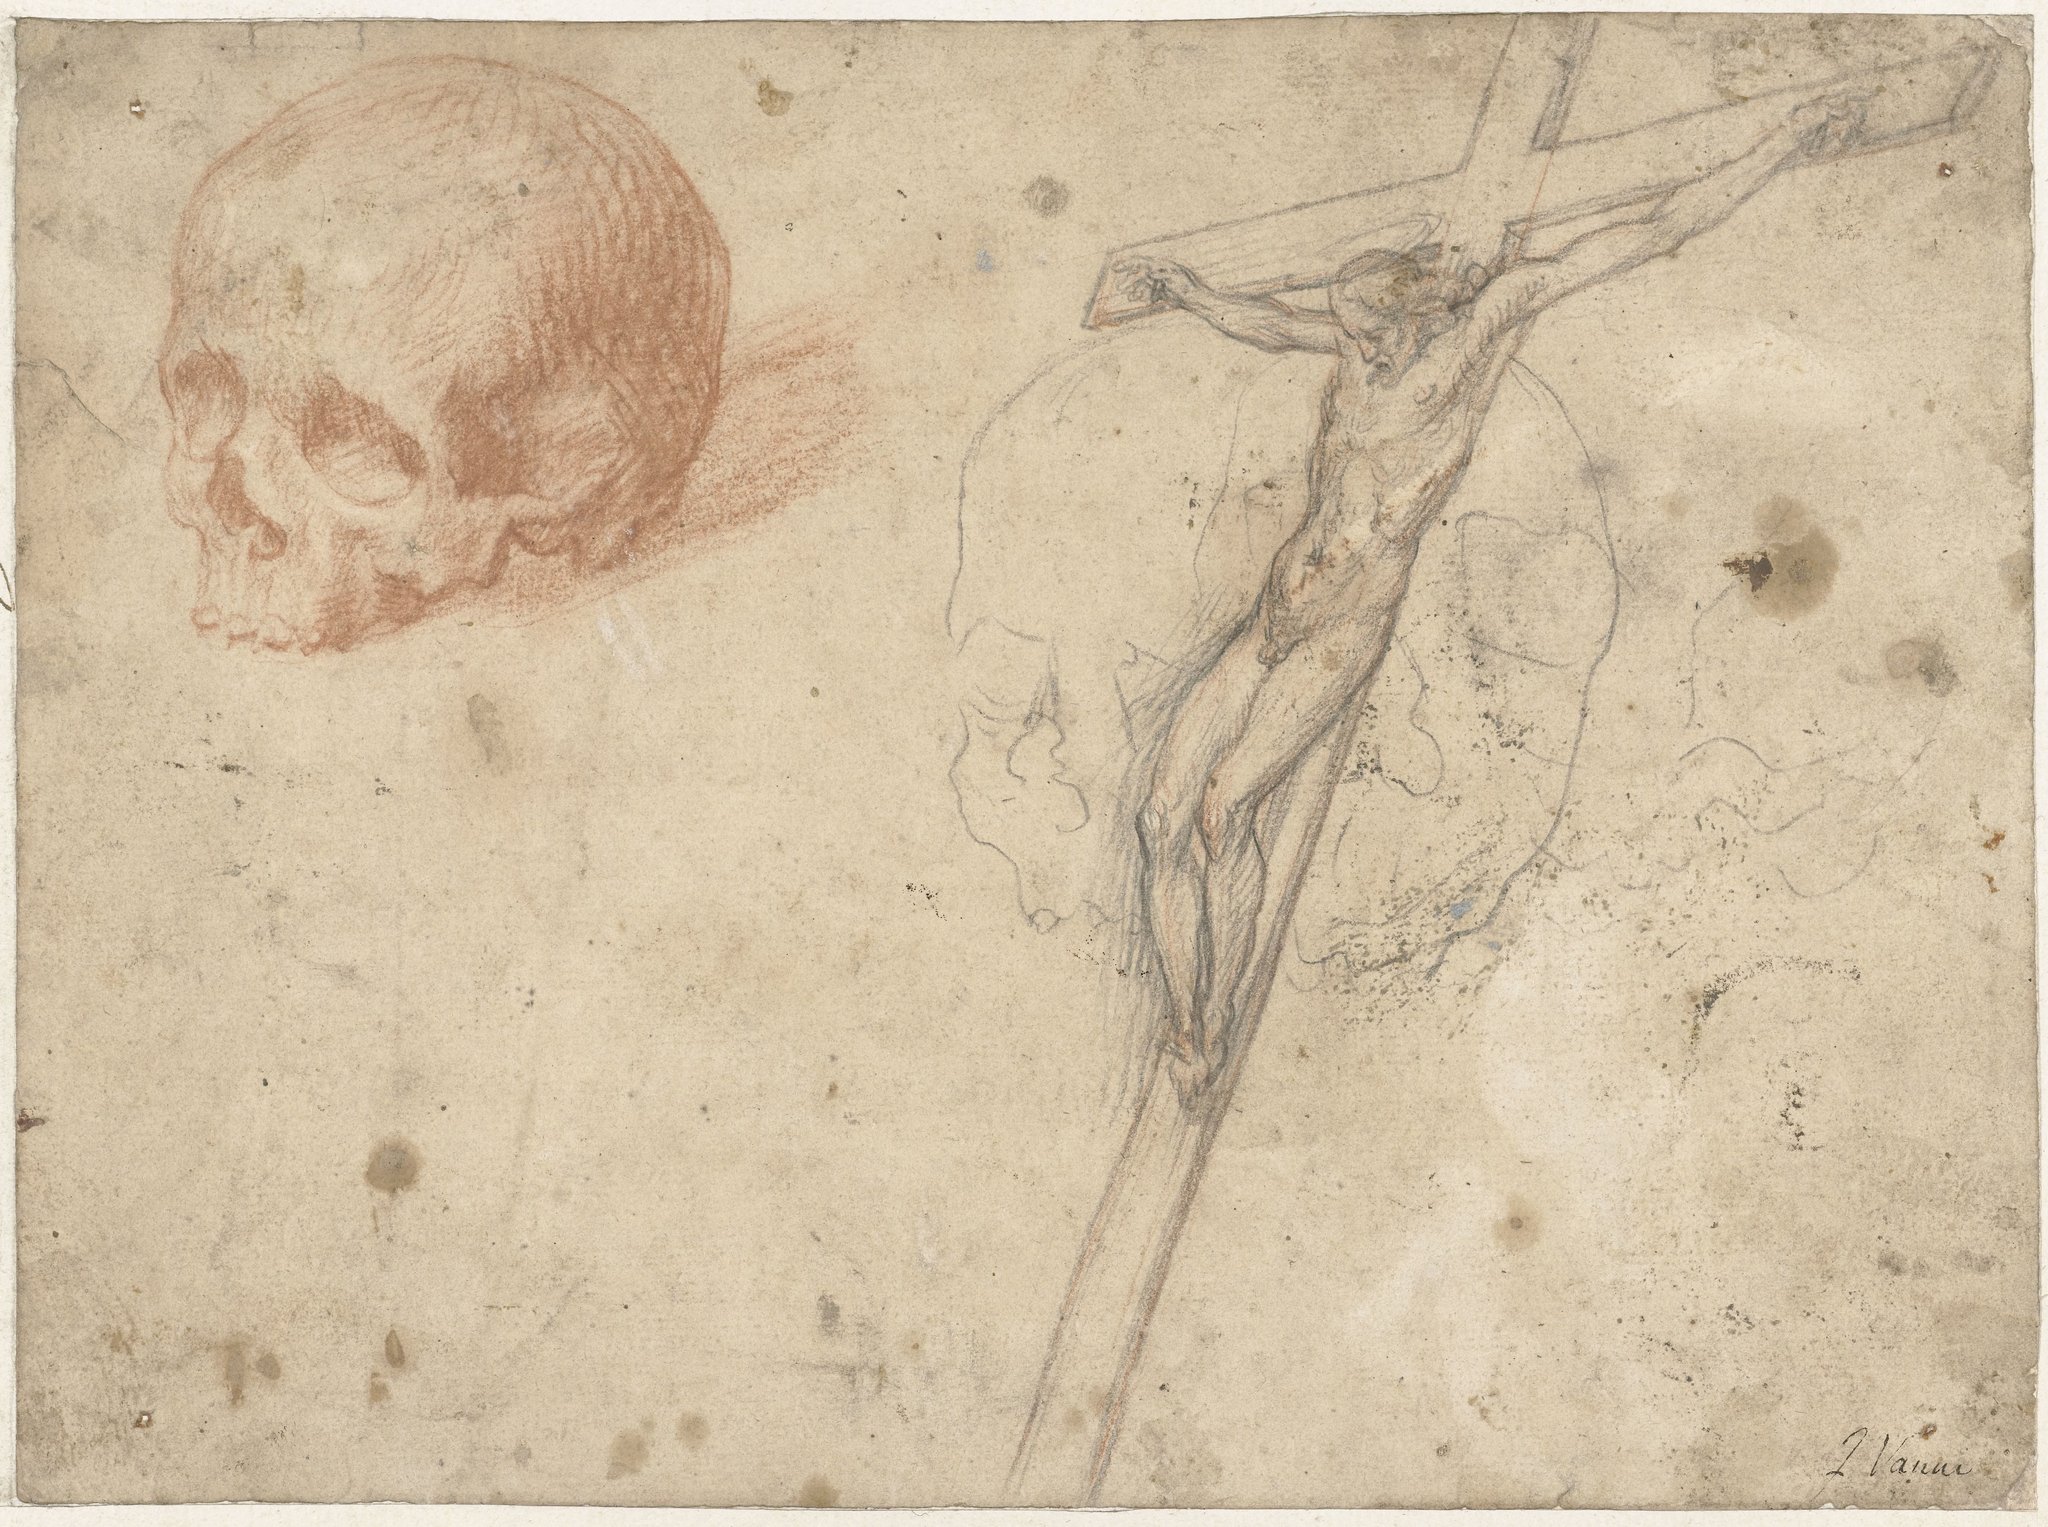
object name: drawing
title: Schets van crucifix en doodshoofd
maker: francesco vanni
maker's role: draughtsman, print maker, publisher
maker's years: 1563-1610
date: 1573-1610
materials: chalk, paper